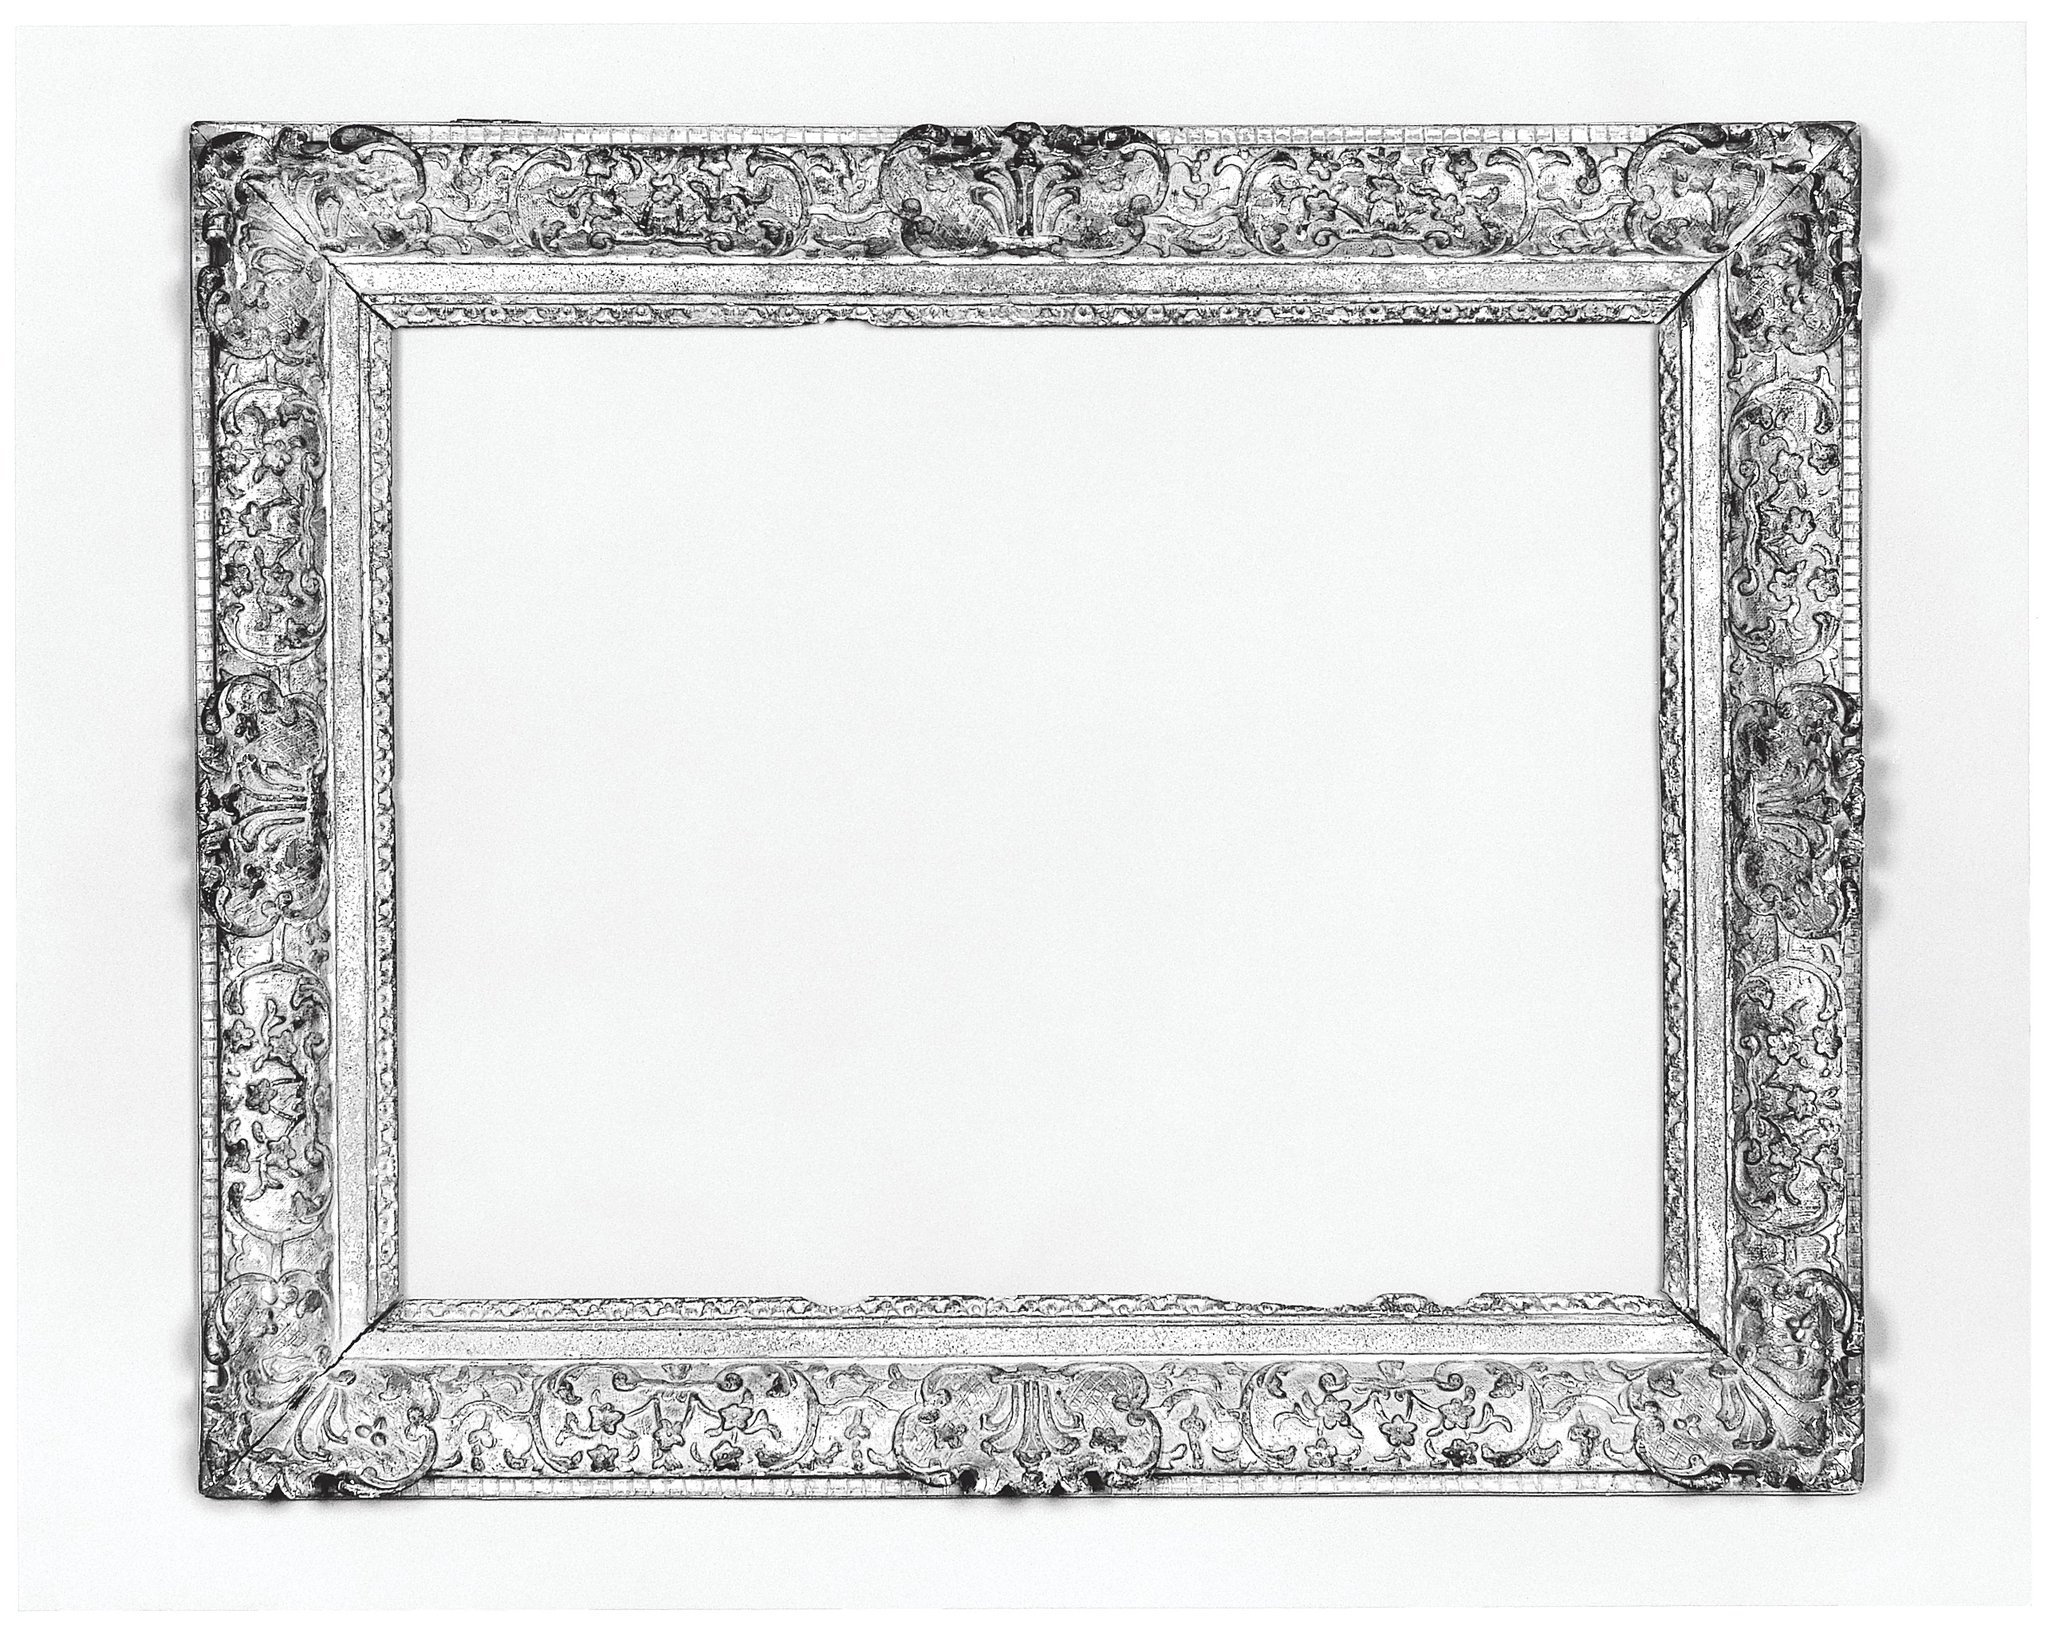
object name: frame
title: Ovolo frame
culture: french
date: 1700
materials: wood